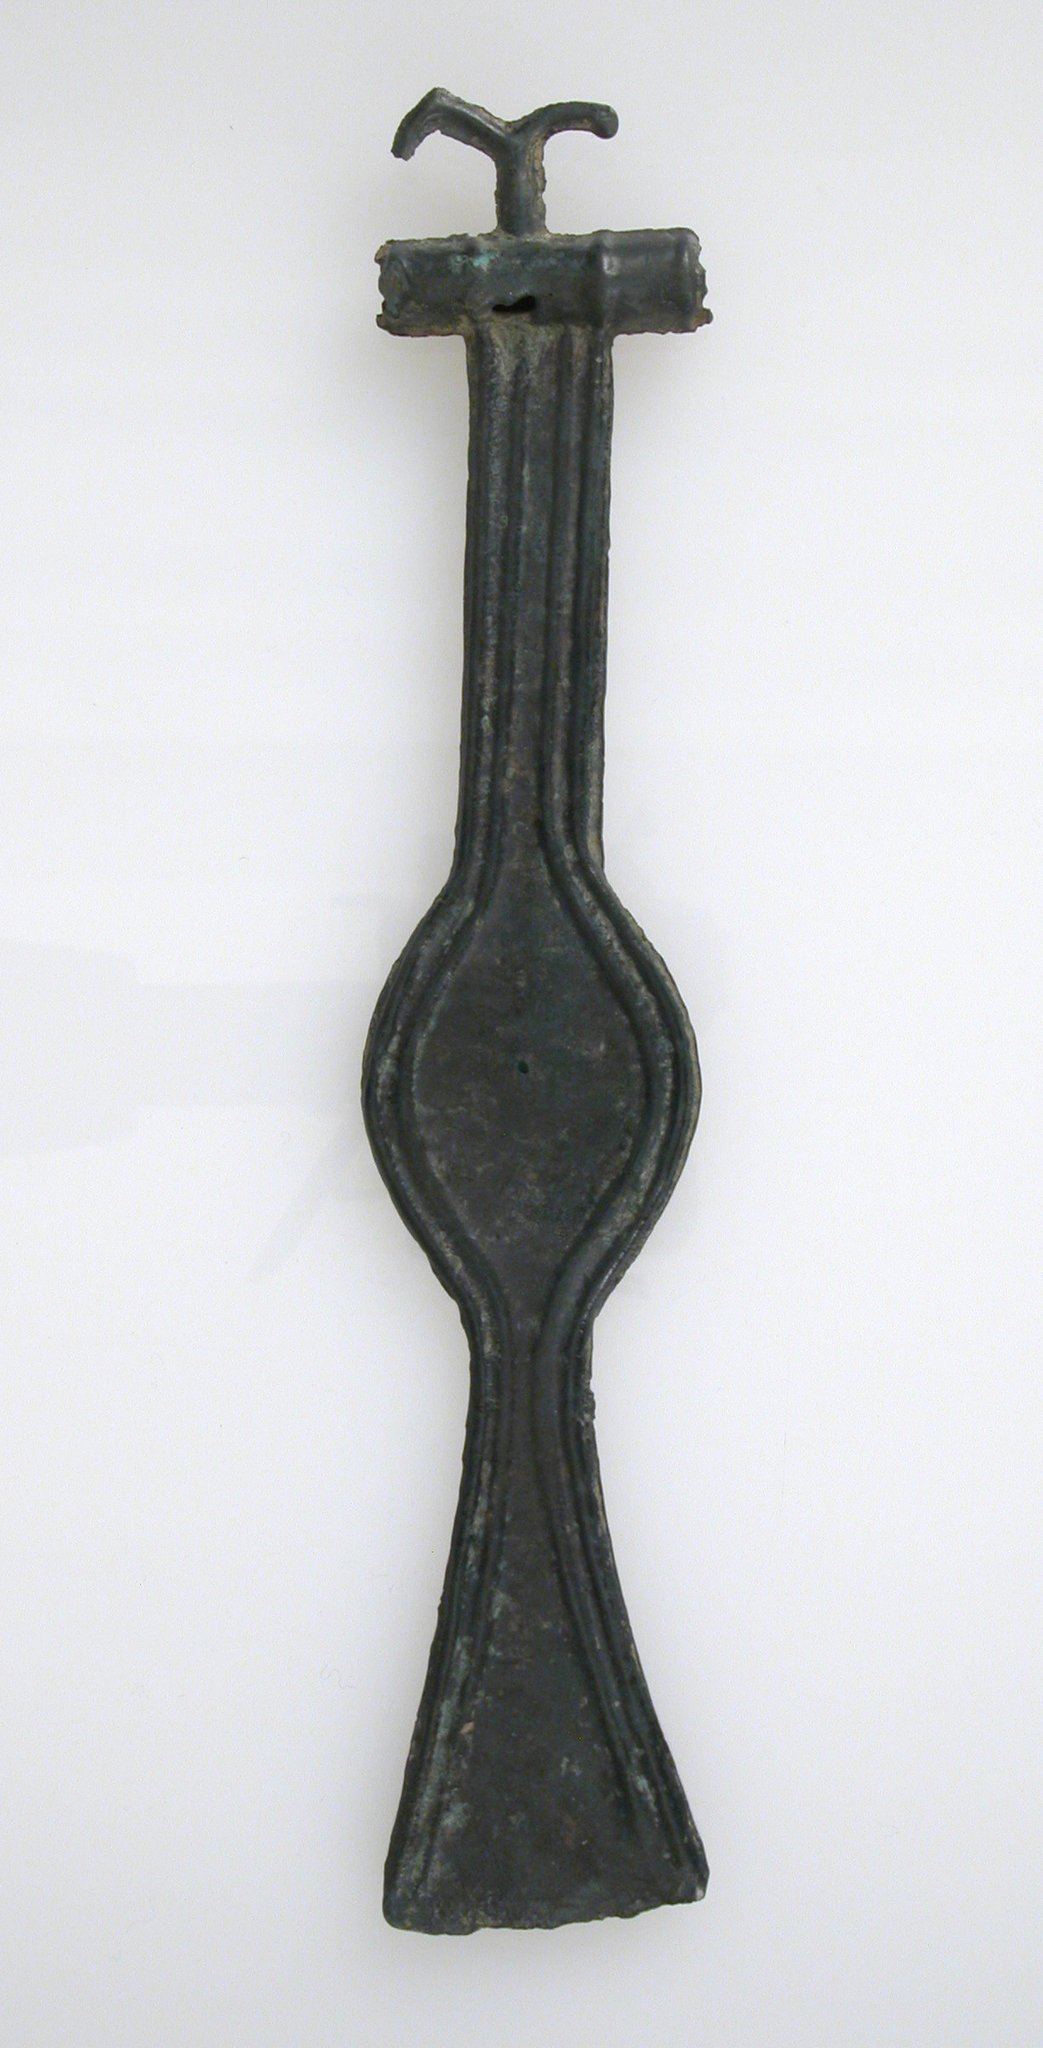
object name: axe blade pendant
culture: european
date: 1200-900 BCE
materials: copper alloy